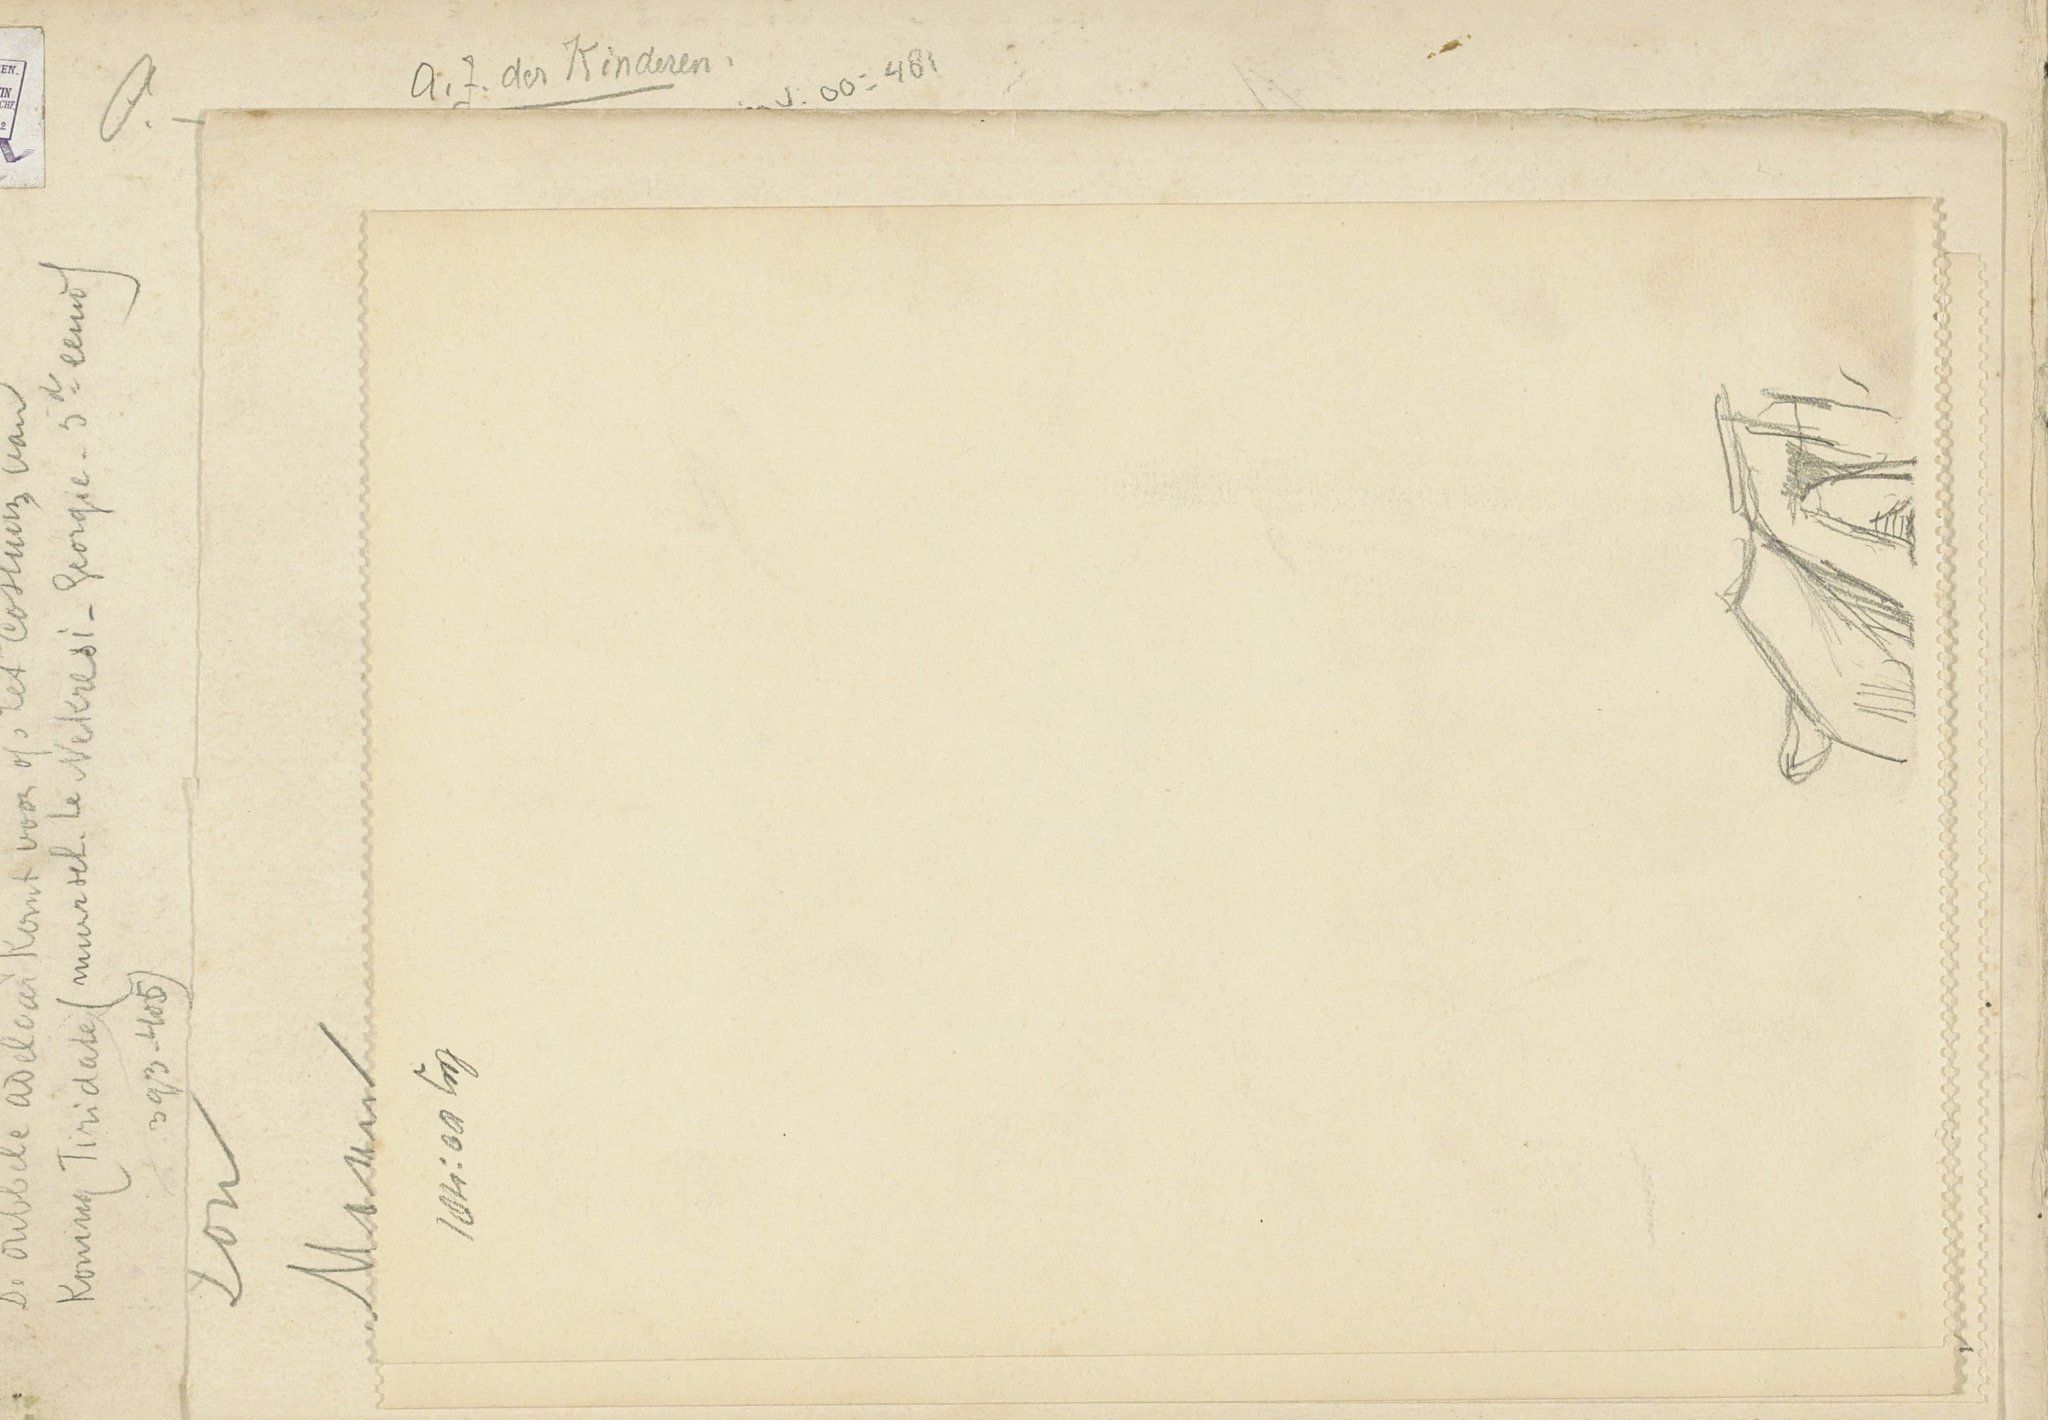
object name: sketchbook leaf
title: Studie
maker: antoon derkinderen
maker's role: draughtsman, painter, print maker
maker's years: 1859-1925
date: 1869-1925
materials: paper, pencil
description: Verso van een losse tekening tussen het voorste schutblad en blad 1 uit een schetsboek met 28 bladen.